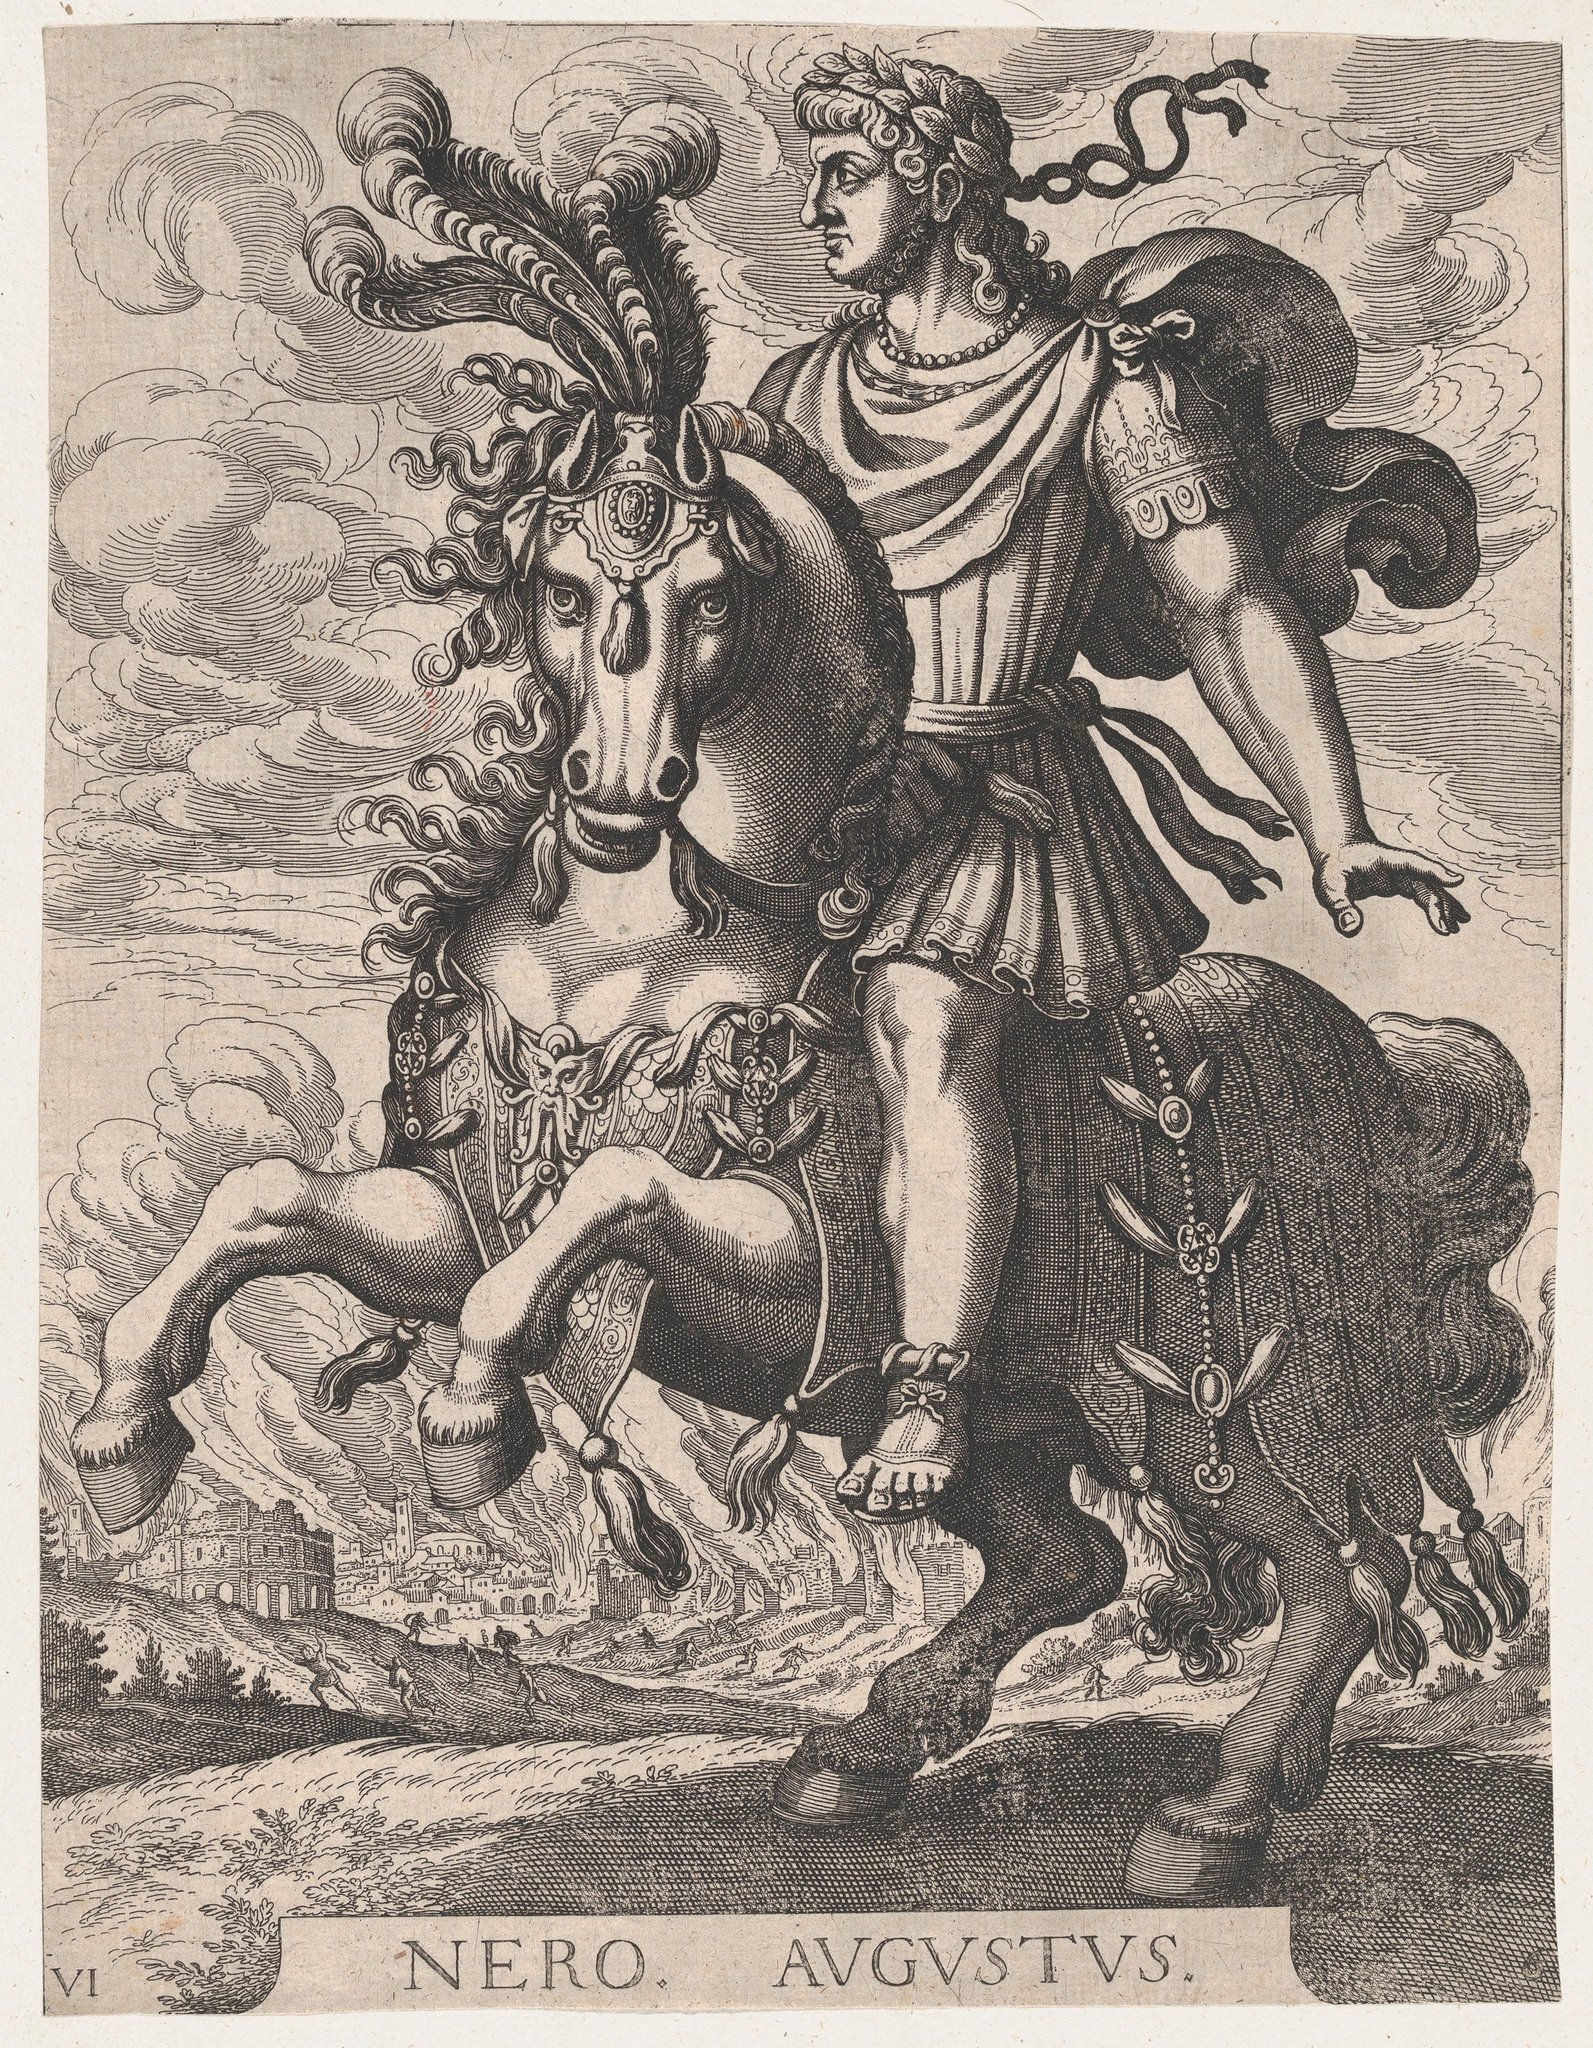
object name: print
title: Plate 6: Emperor Nero on Horseback, from 'The First Twelve Roman Caesars', after Tempesta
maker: matthäus merian the elder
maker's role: artist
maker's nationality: swiss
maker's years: 1593-1650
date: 1610-1650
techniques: engraving, etching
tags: men,horses